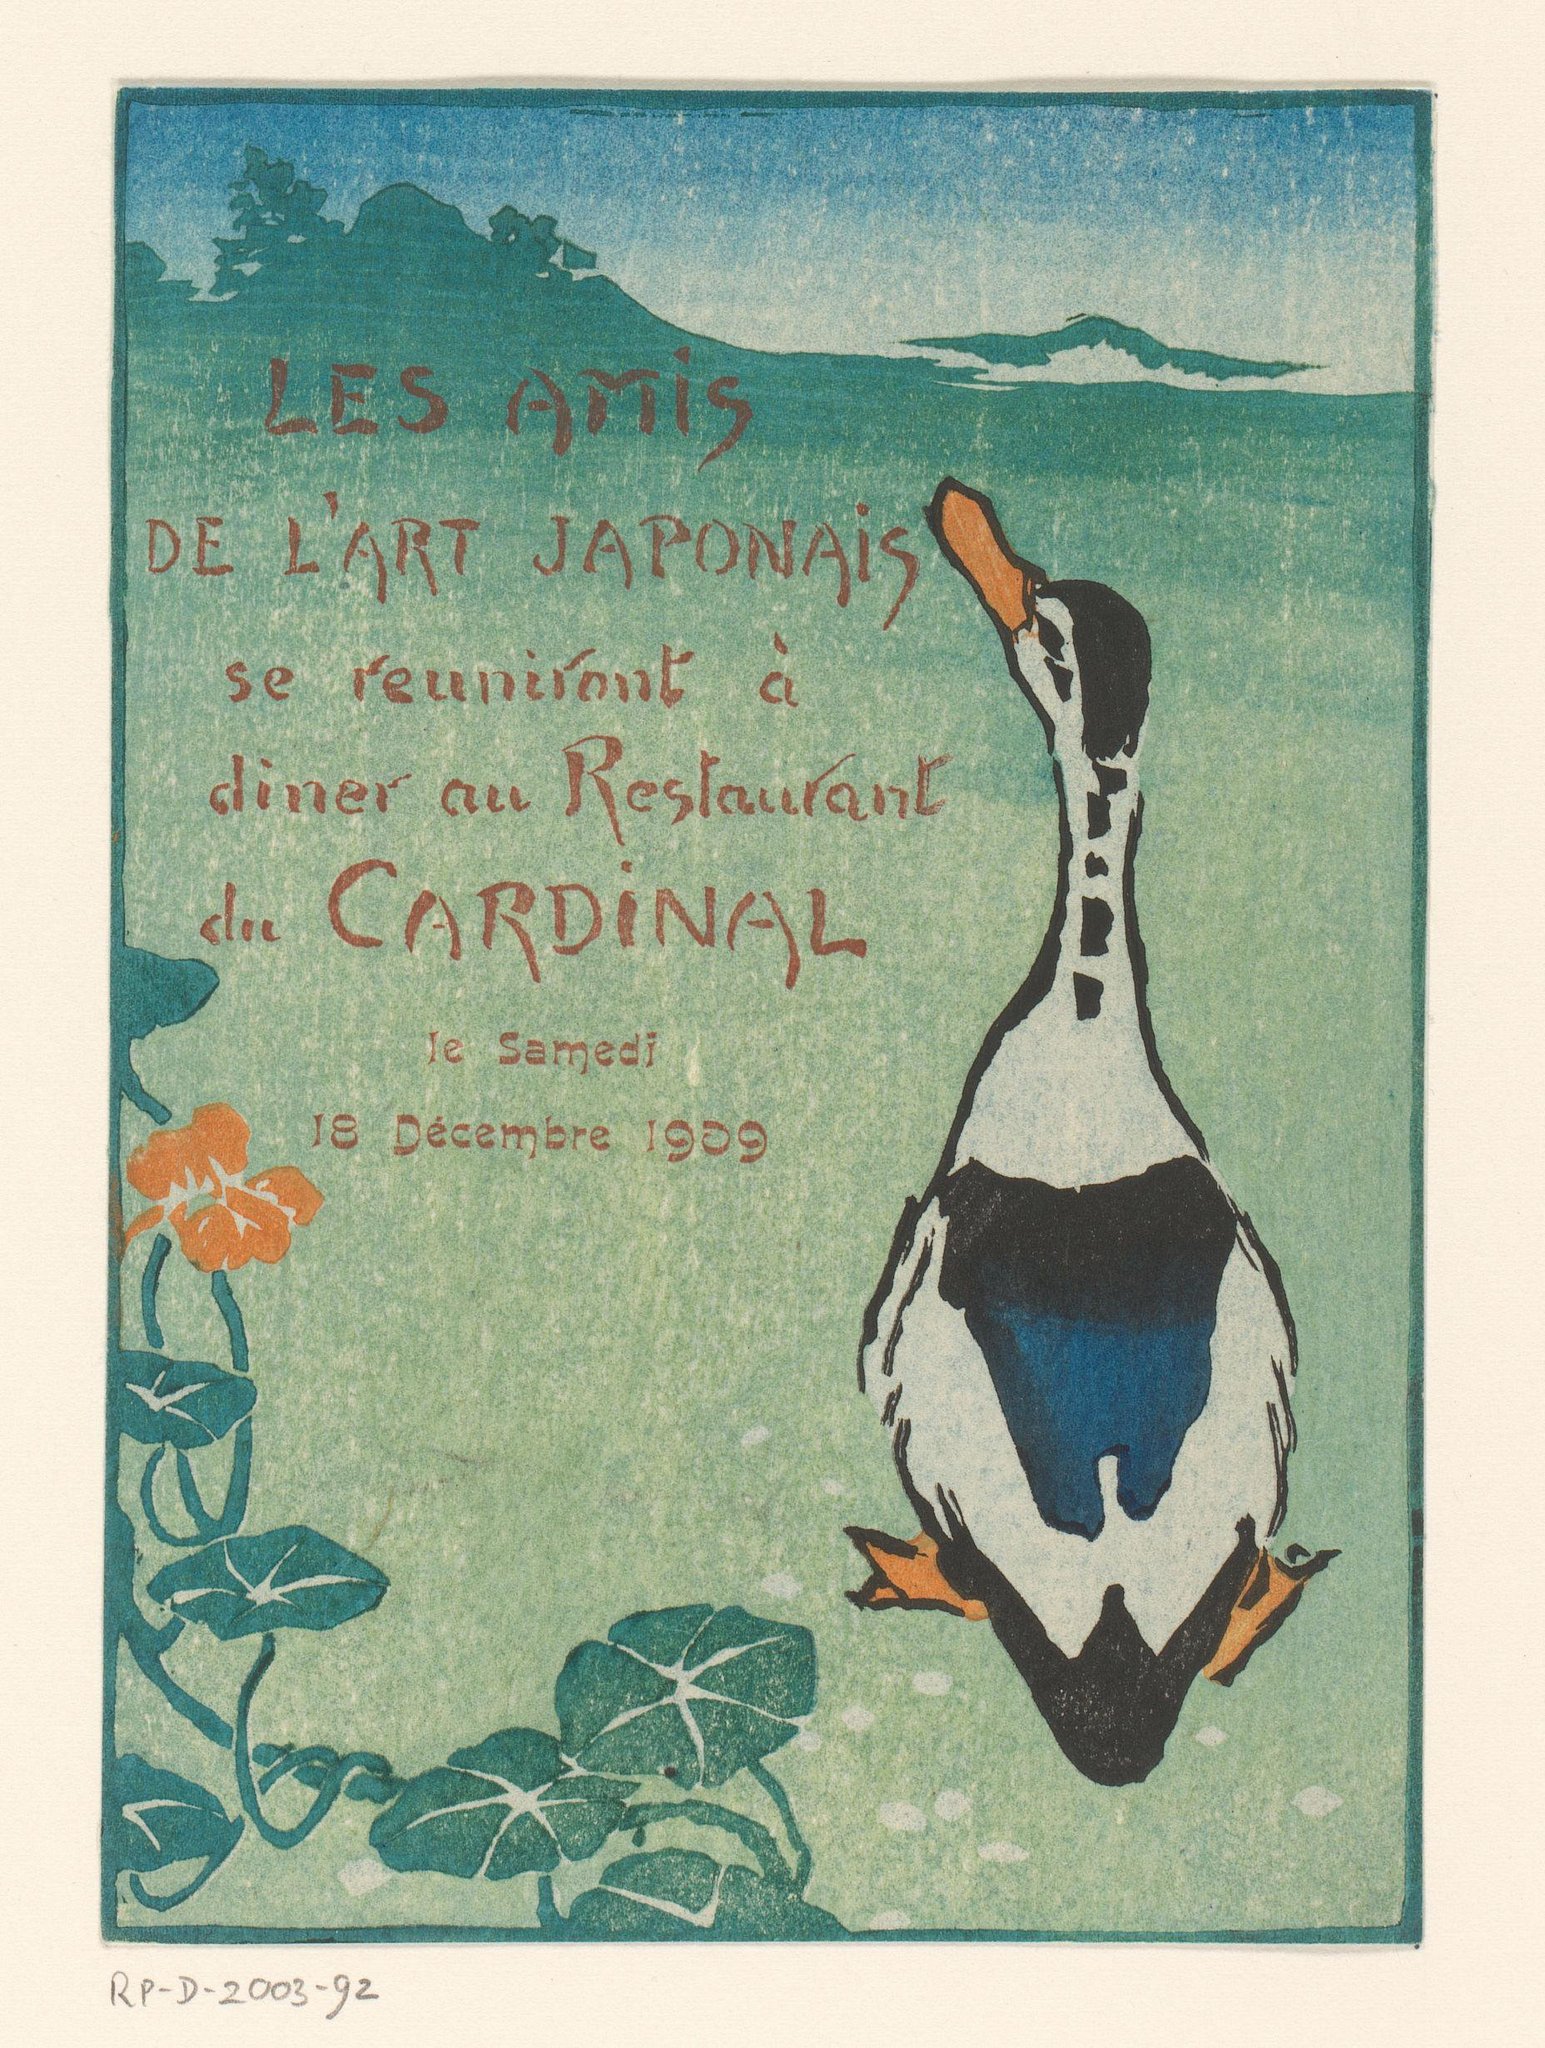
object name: print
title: Uitnodiging voor een diner van Les Amis de l'Art Japonais, 18 december 1909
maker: jules chadel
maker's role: draughtsman, print maker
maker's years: 1870-1941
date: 1909-1912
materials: paper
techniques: woodcut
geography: france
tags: ducks (domestic waterbirds), water-birds: duck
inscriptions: collector's mark: Lugt 2228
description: Eend met wingerd. Uitnodiging voor een diner van Les Amis de l'Art Japonais, 18 december 1909.